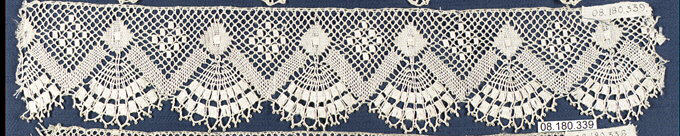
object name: piece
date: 1801-1900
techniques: lace